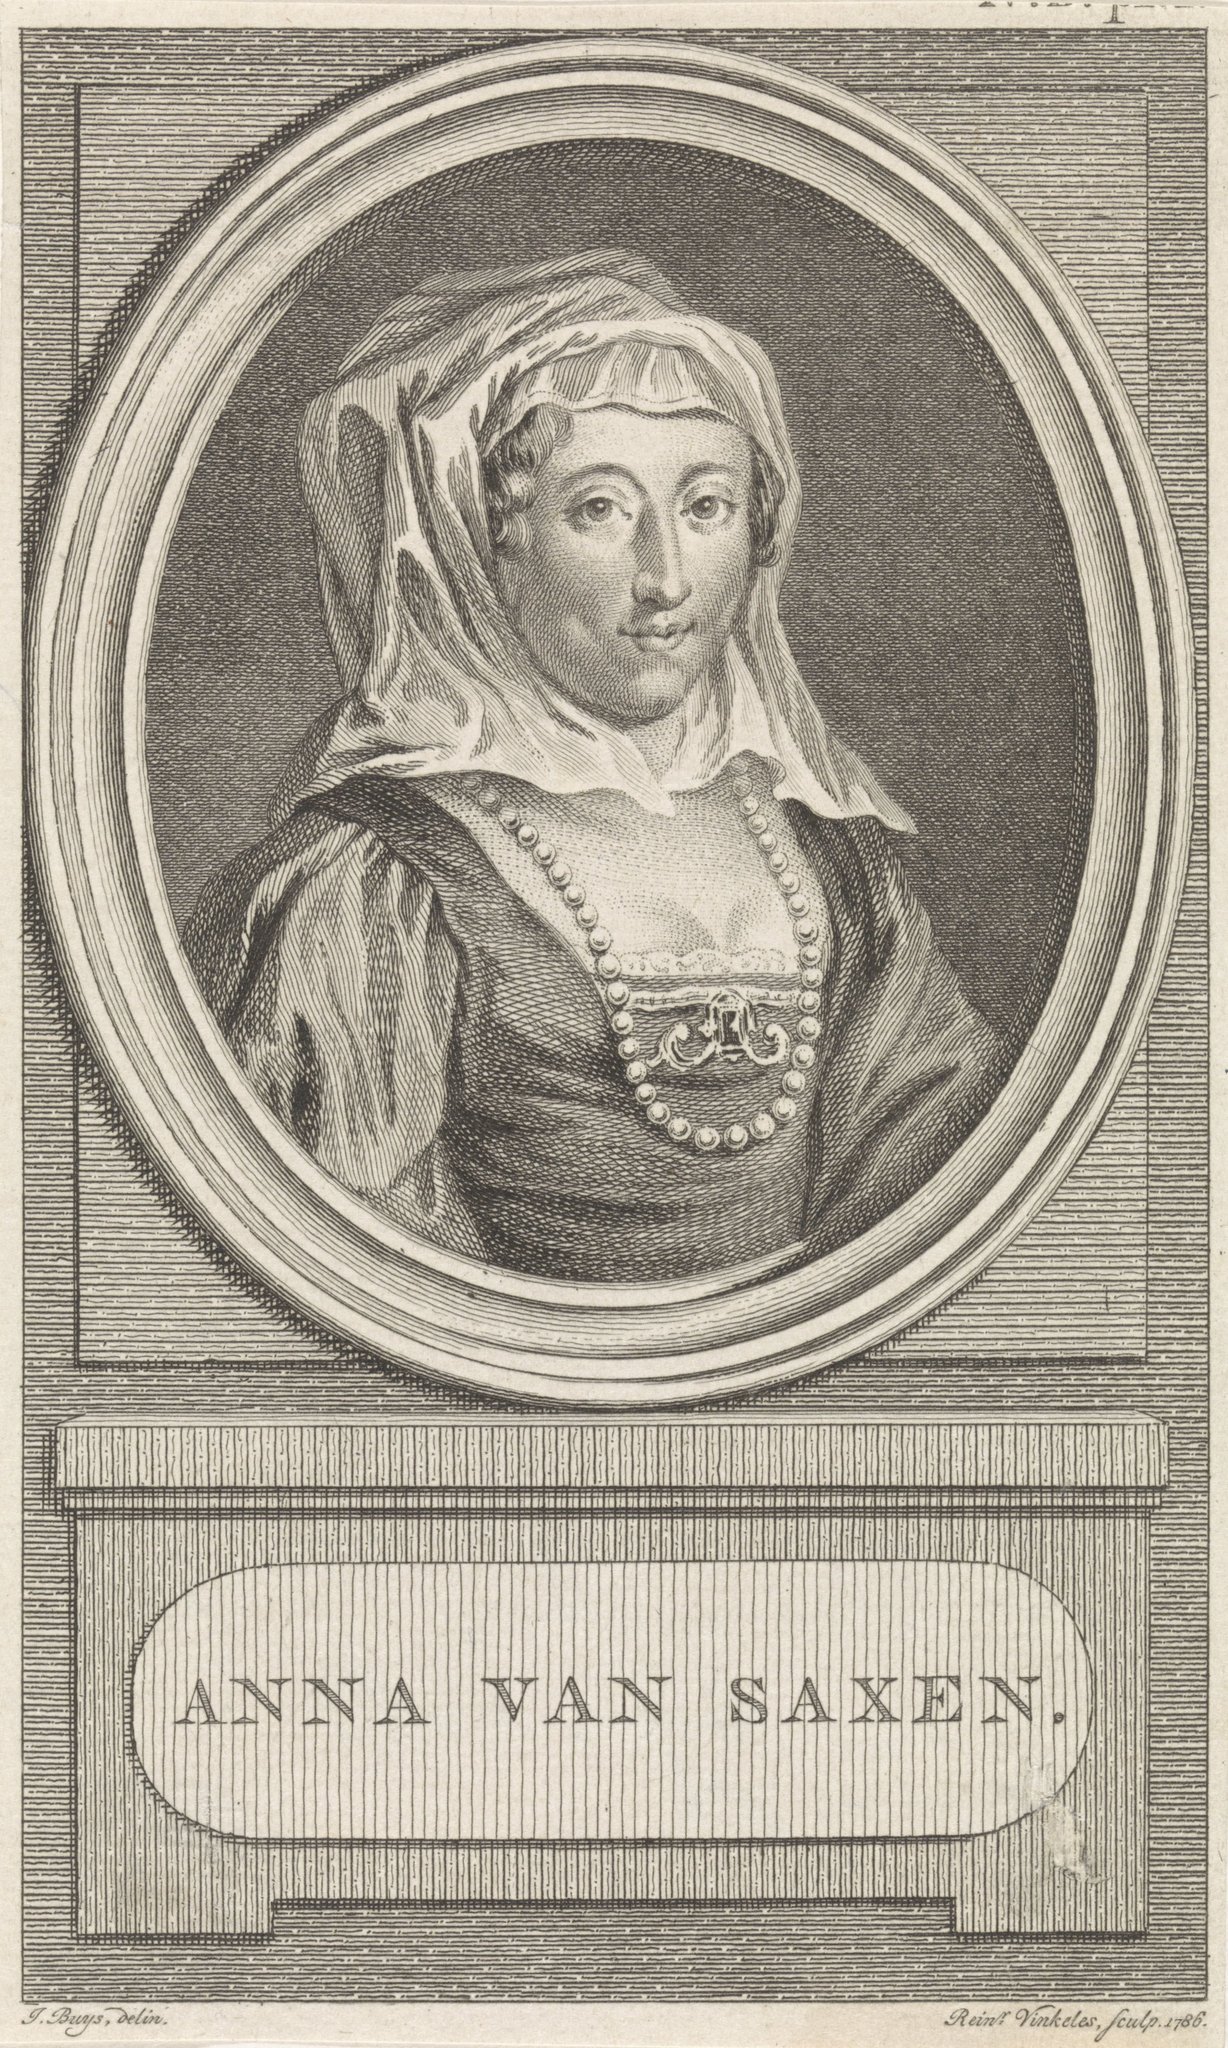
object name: book illustration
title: Portret van Anna van Saksen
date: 1786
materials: paper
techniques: engraving, etching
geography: amsterdam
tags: dresden, anna van saksen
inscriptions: collector's mark: Lugt 2228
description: Prent gebruikt als boekillustratie in: Kok, Jacobus. Vaderlandsch woordenboek : met kaarten, plaaten en pourtraitten. Amsterdam: Johannes Allart, 1785-1796. Deel IV.